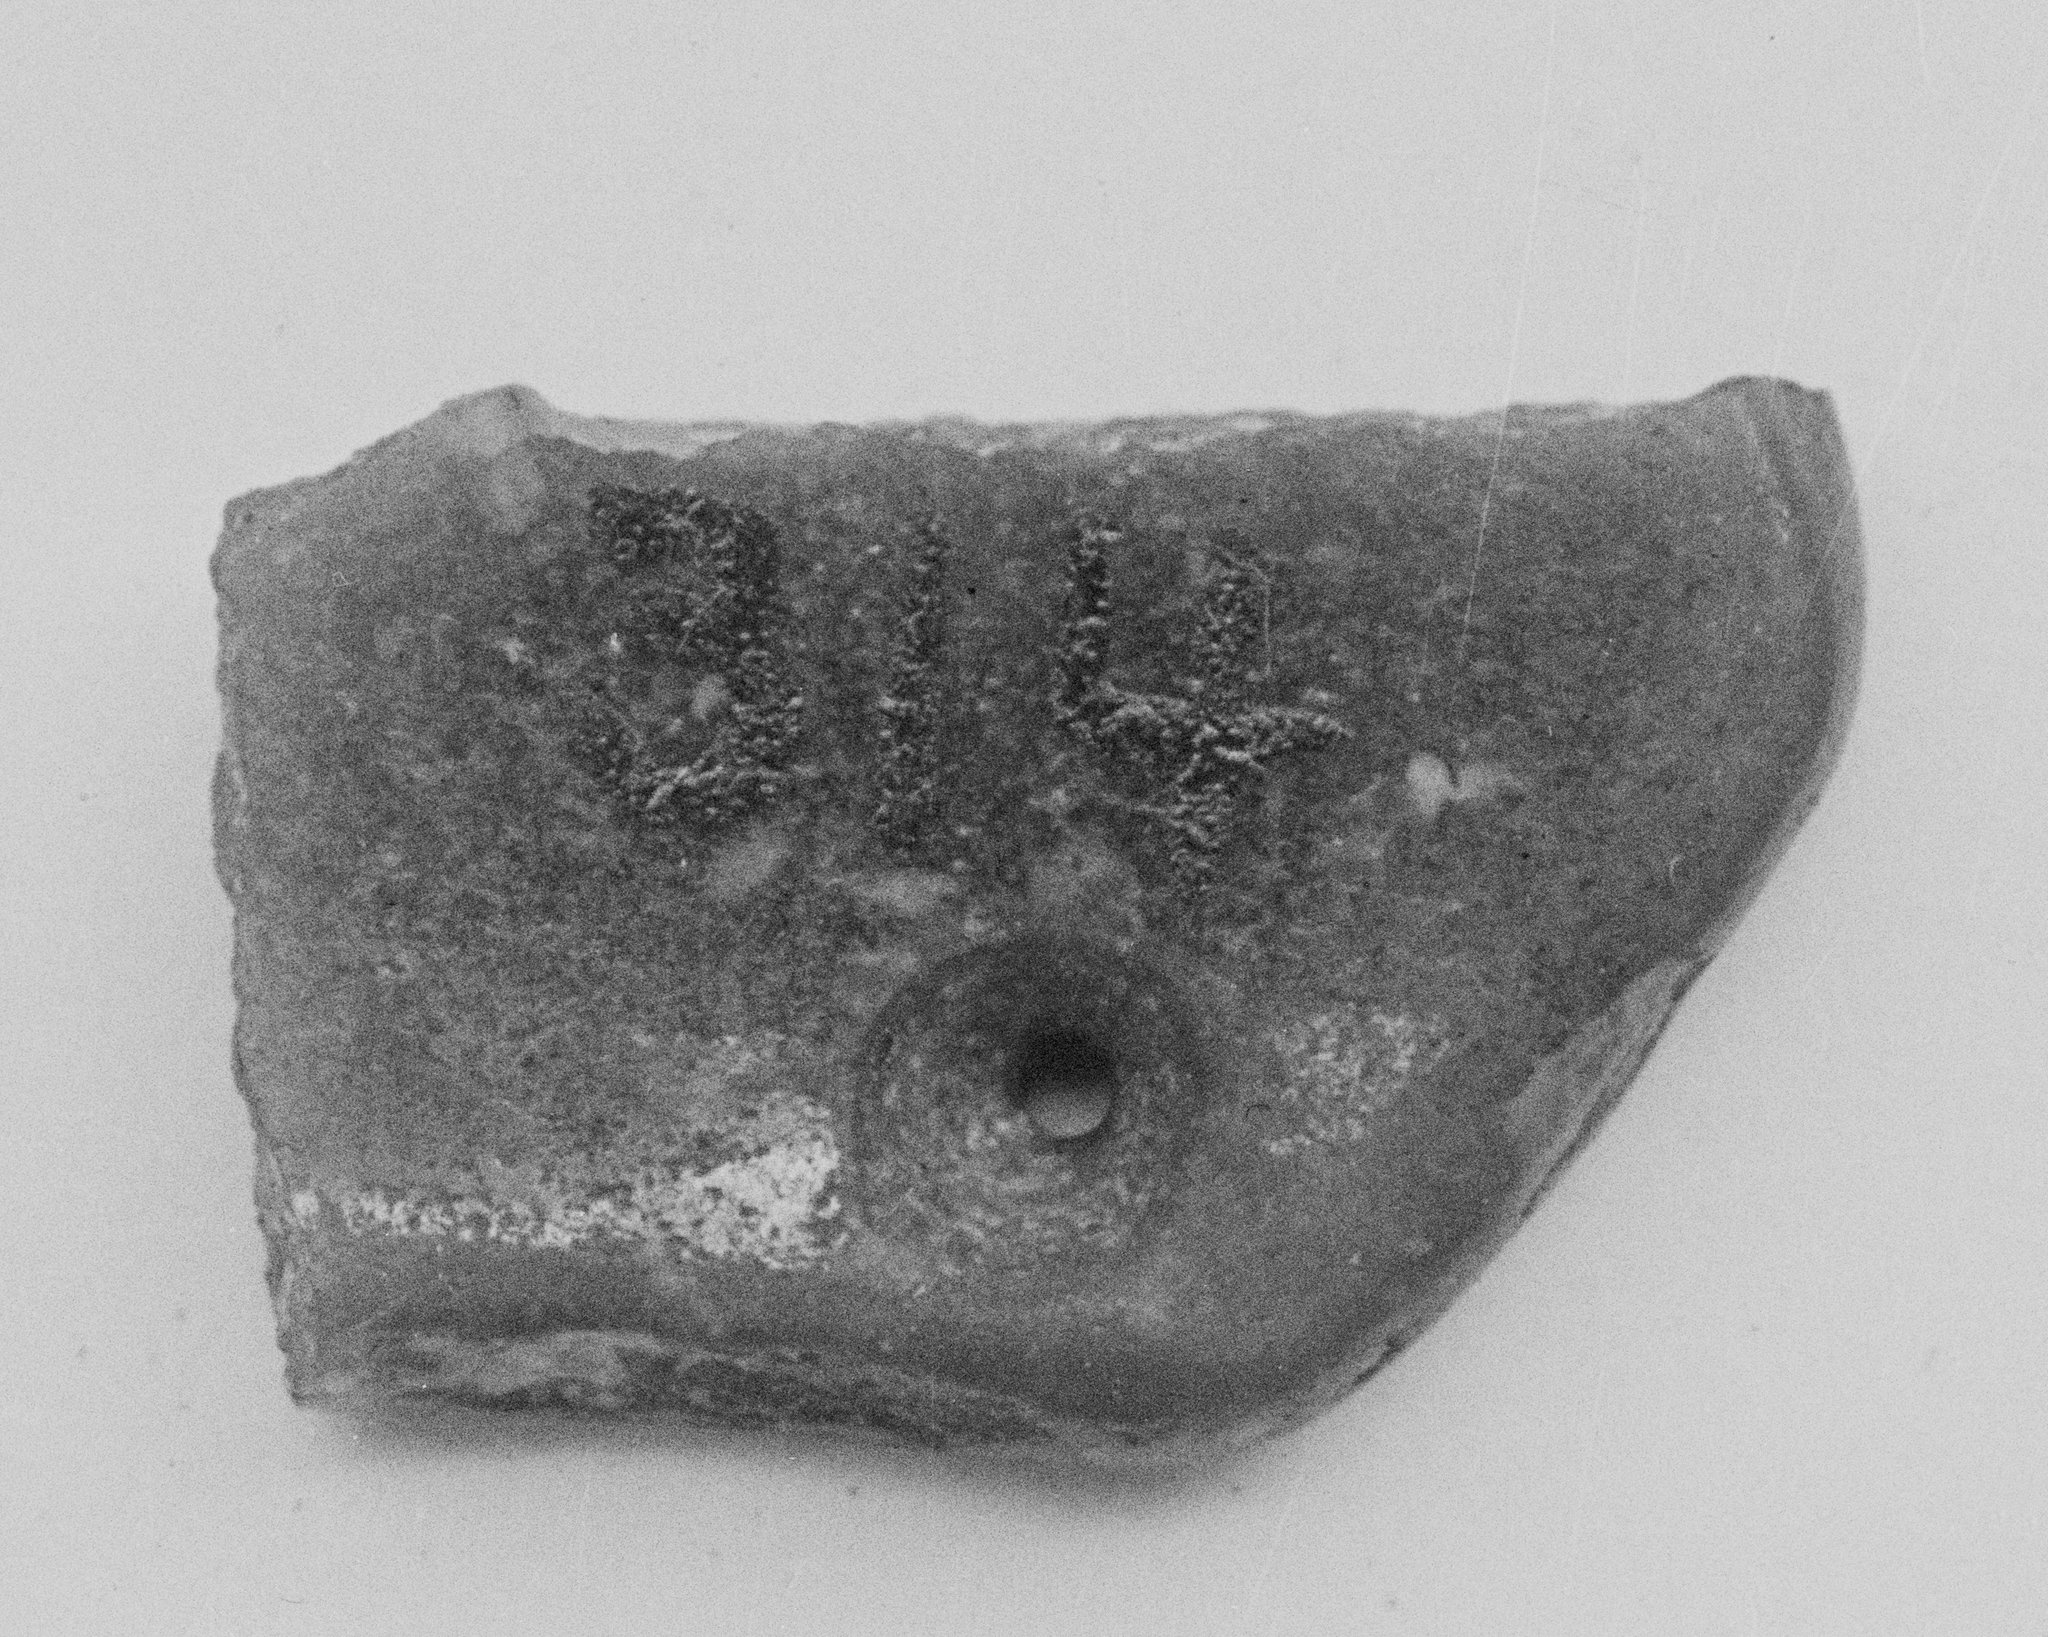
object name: pendant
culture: mexican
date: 1902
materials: jade